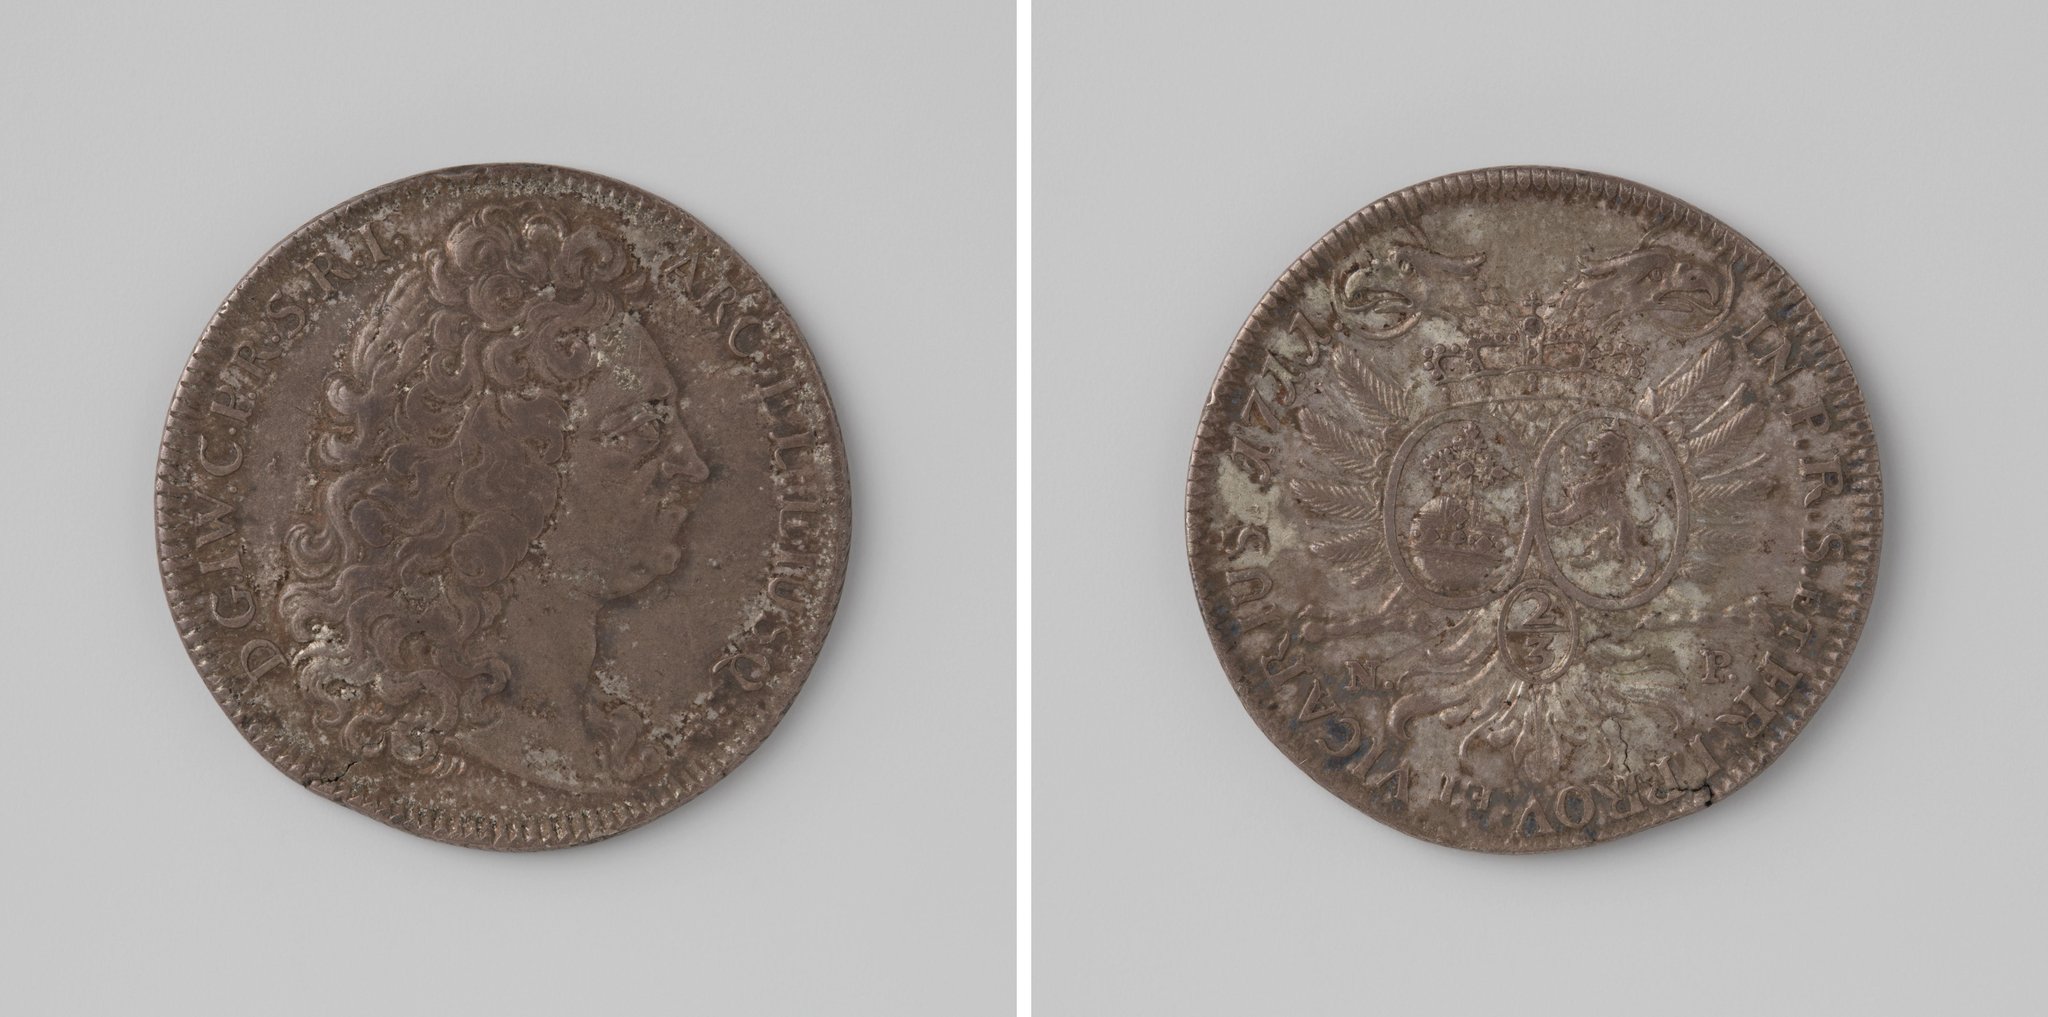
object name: halve taler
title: Johan Willem, keurvorst van de Palts, na de dood van keizer Jozef I aangesteld als stadhouder van Schwaben, Frankenland en de Palts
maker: nikolaus prück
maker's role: mintmaster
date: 1711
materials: silver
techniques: striking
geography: dusseldorf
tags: düsseldorf, hertog, keurvorst, johann wilhelm von der pfalz, zwaben, palts, frankenland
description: Voorzijde: borststuk man binnen omschrift. Keerzijde: tweekoppige adelaar met twee wapenschilden onder een kroon binnen omschrift